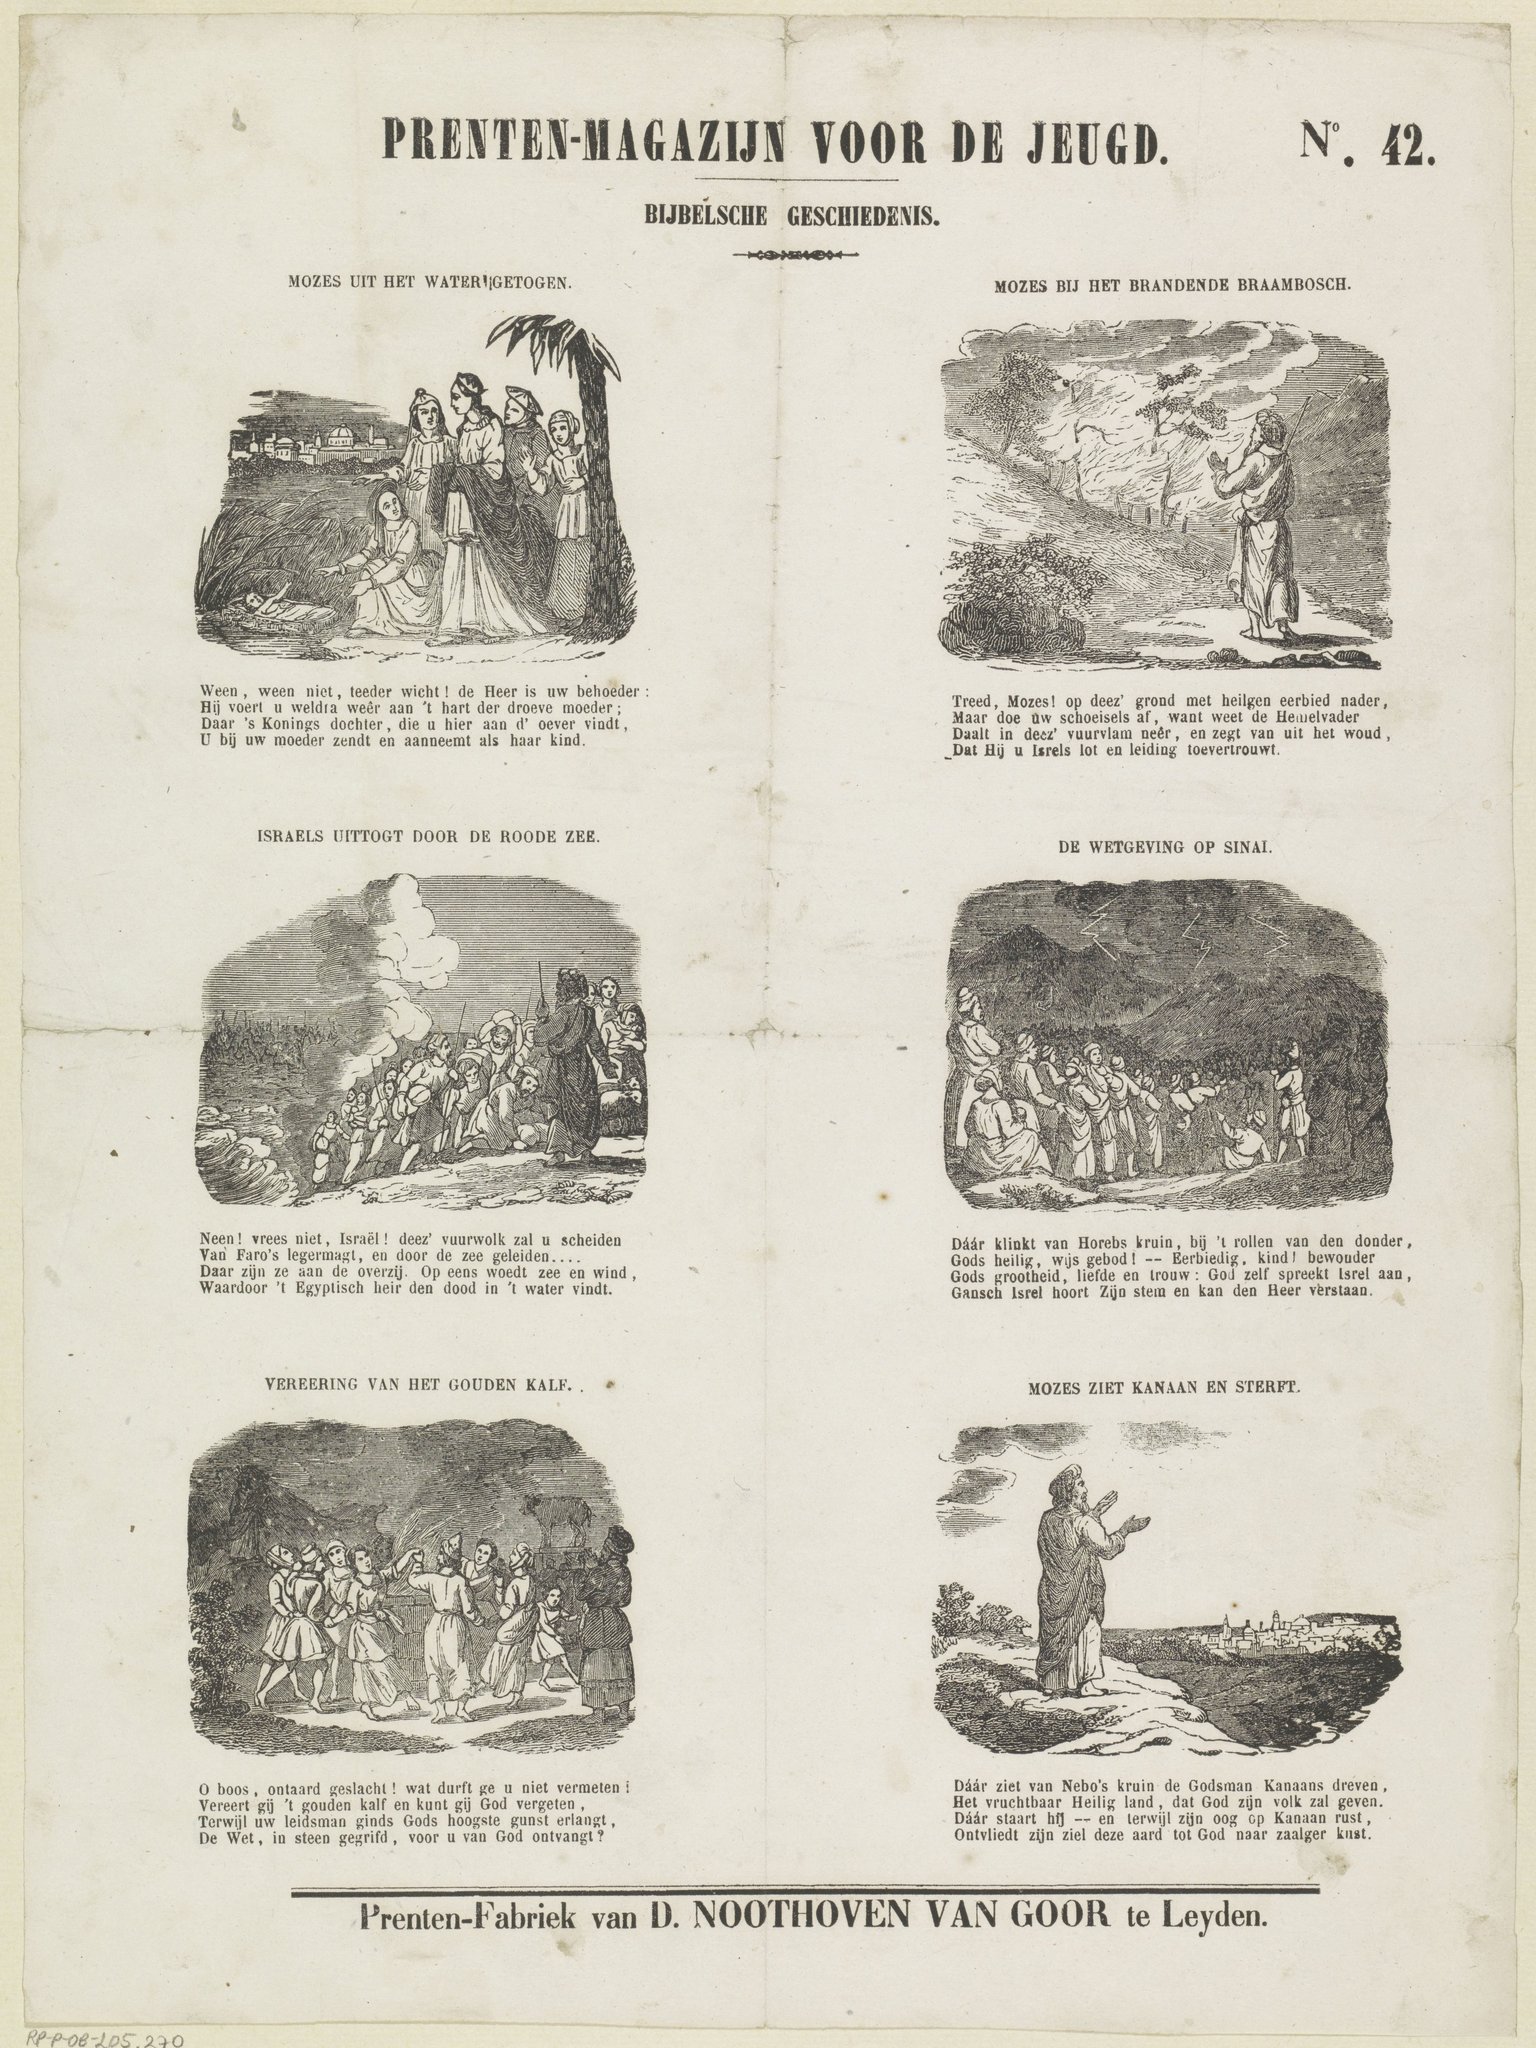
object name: print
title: Prenten-magazijn voor de jeugd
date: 1850-1881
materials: paper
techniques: letterpress printing, engraving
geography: netherlands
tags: exodus, leviticus, numbers, deuteronomy, joshua: from the bondage of the israelites in egypt to their settlement in canaan, old testament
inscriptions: collector's mark: Lugt 2760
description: Blad met 6 voorstellingen uit het oudtestamentische verhaal van Mozes. Boven elke voorstelling een titel en onder elke voorstelling een vierregelig vers. Genummerd rechtsboven: No. 42.